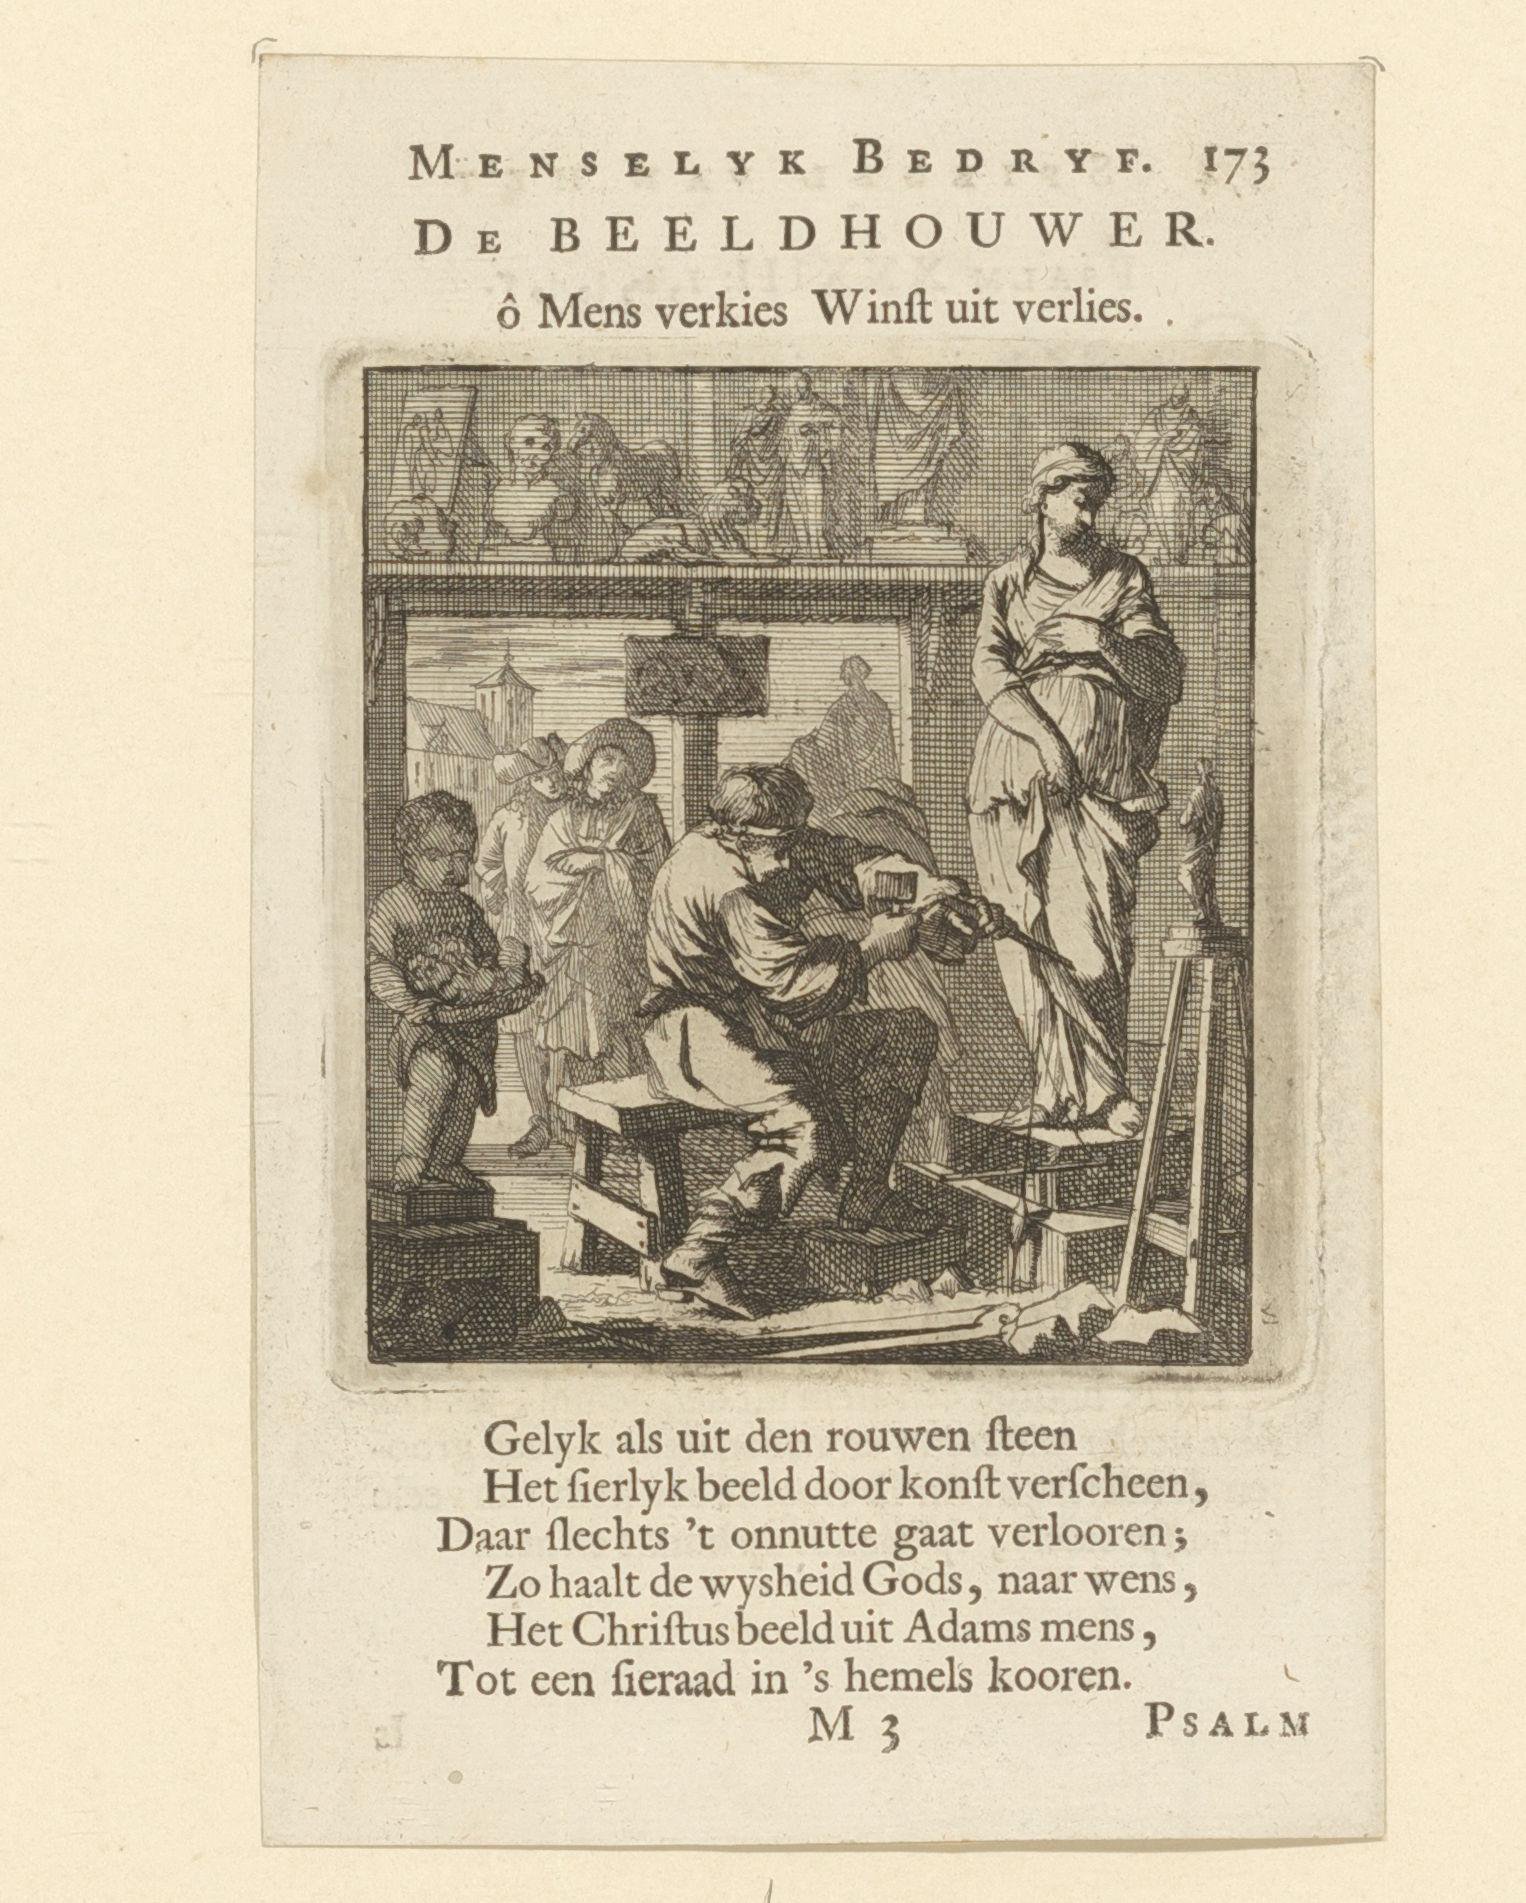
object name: book illustration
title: Beeldhouwer in zijn atelier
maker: cornelis van der sys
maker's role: publisher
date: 1718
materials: paper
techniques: etching, letterpress printing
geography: amsterdam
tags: handicrafts, craftsman at work, sculptor at work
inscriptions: collector's mark: Lugt 1641, stamp, stamp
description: Prent oorspronkelijk verschenen in de 100-delige serie beroepsprenten van Jan en Caspar Luyken, getiteld: Het menselyk bedryf. S.l.s.n., 1694 (eerste druk). Daarna is de titel en het vers afgesneden. De prenten in diverse publicaties verschenen en gekopieerd. Huidige staat uit: Luyken, Jan en Caspar. Spiegel van het menselyk bedryf (...). Amsterdam: Cornelis van der Sys, 1718, p. 173. Prent waarschijnlijk ook gebruikt in eerdere (1704) en latere (1730, 1749, 1767) publicaties.